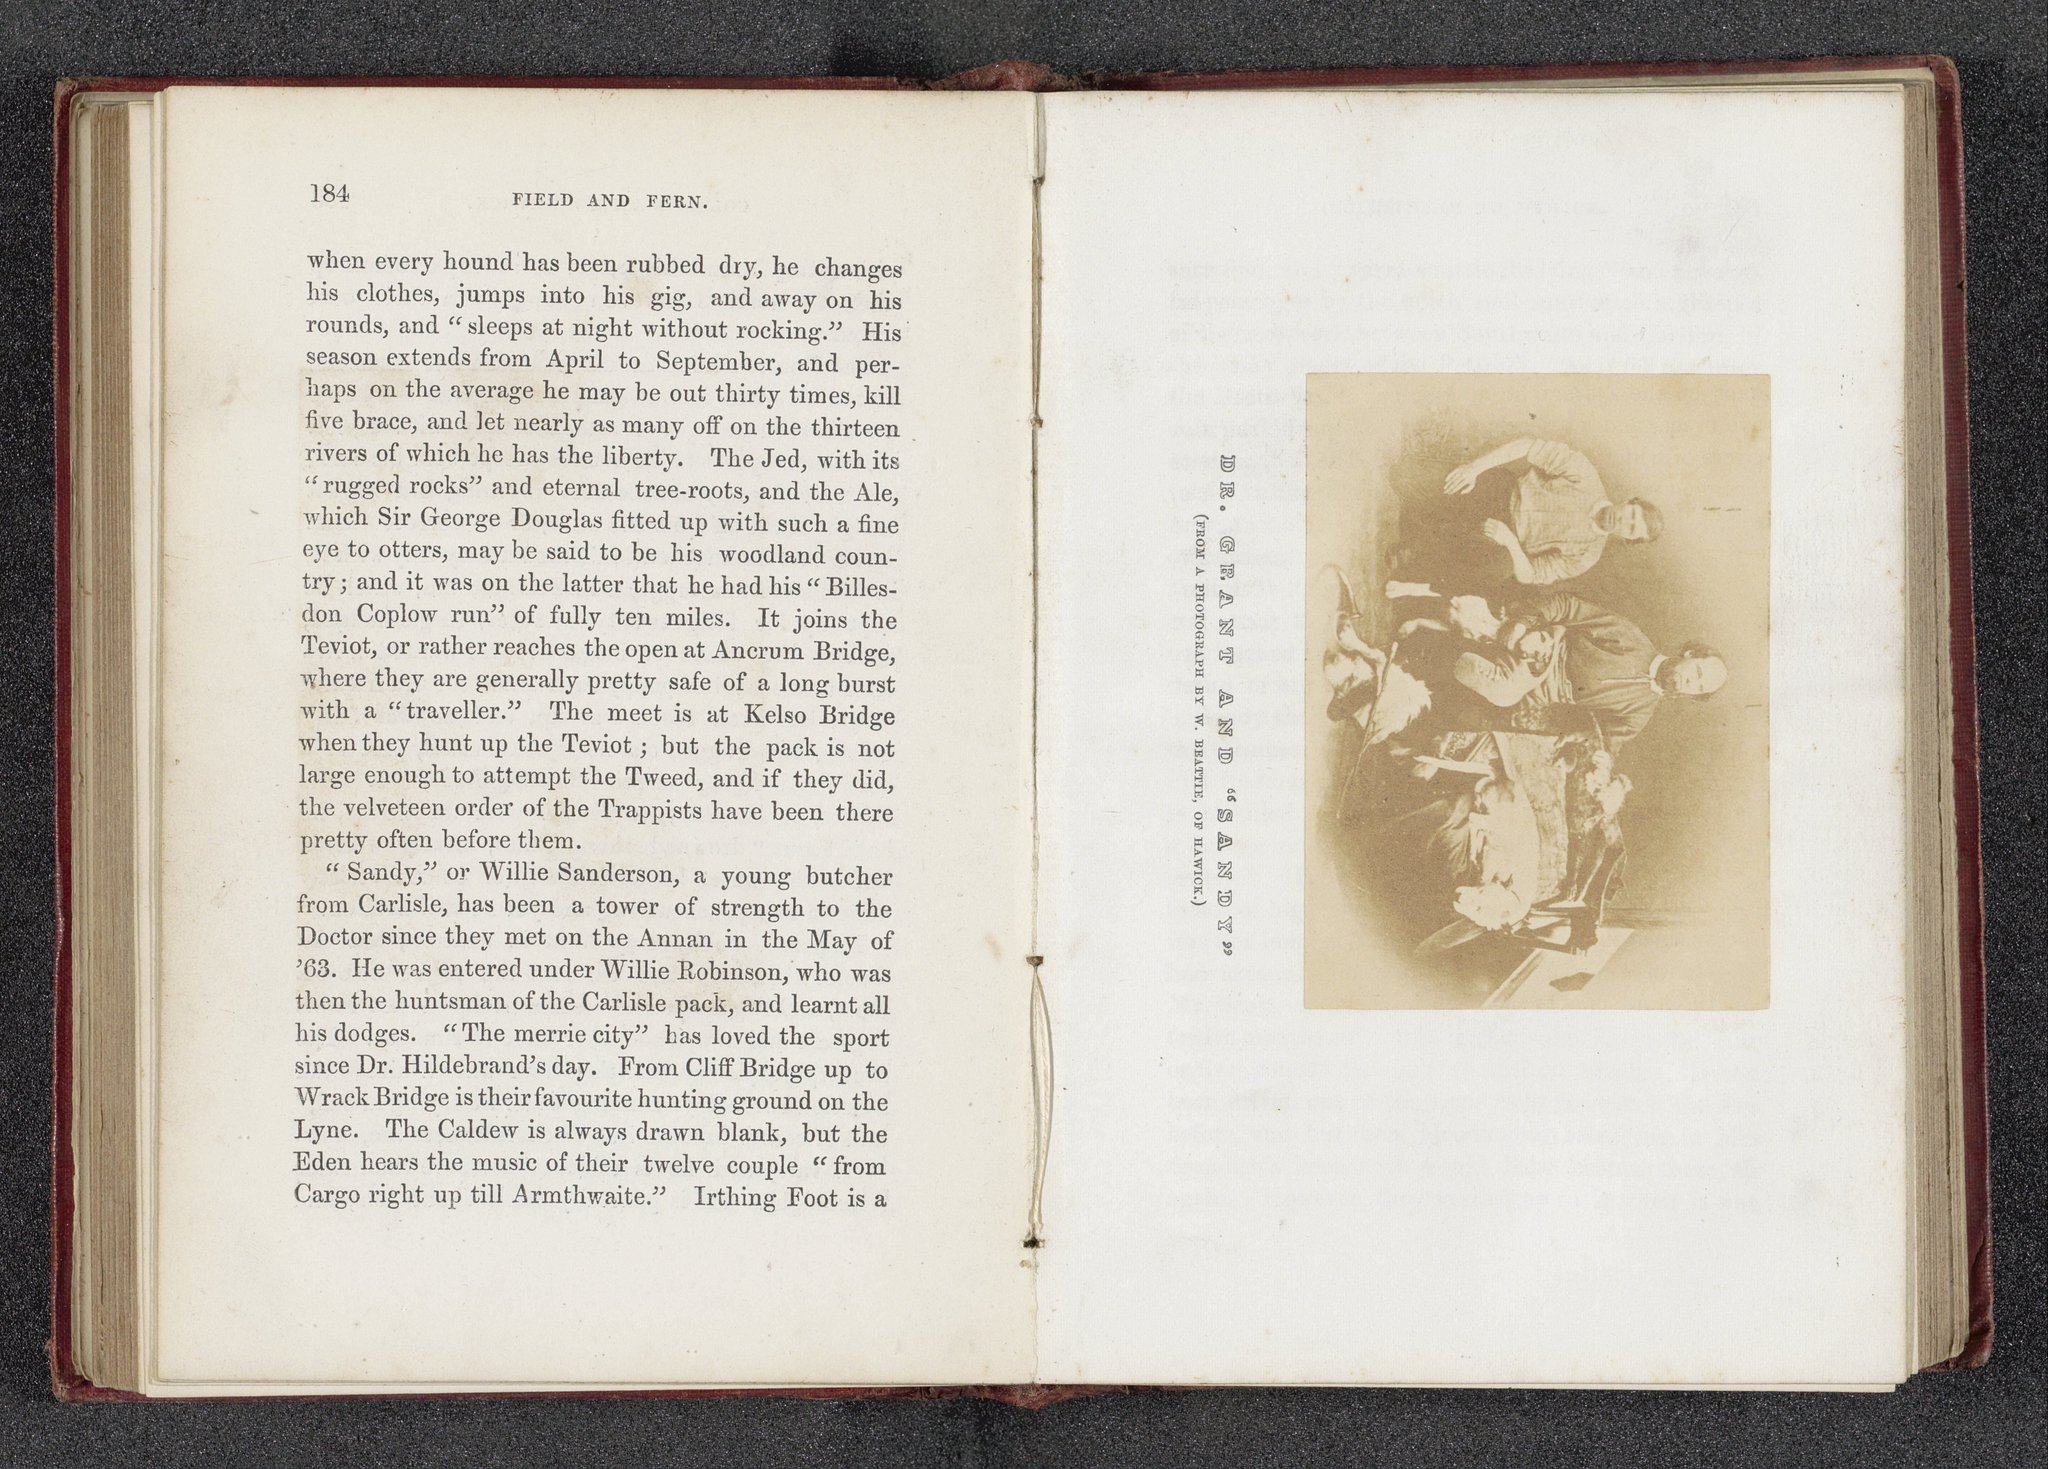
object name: photograph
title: A Glimpse of Knockhill, 1864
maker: scott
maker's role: fotograaf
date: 1864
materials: photographic support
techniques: albumen print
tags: adult man, horse, dog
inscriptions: inscription: ‘(From a Photograph, the sole Property of the Author, taken by Scott, of Carlise, and registred according to the Act.)’